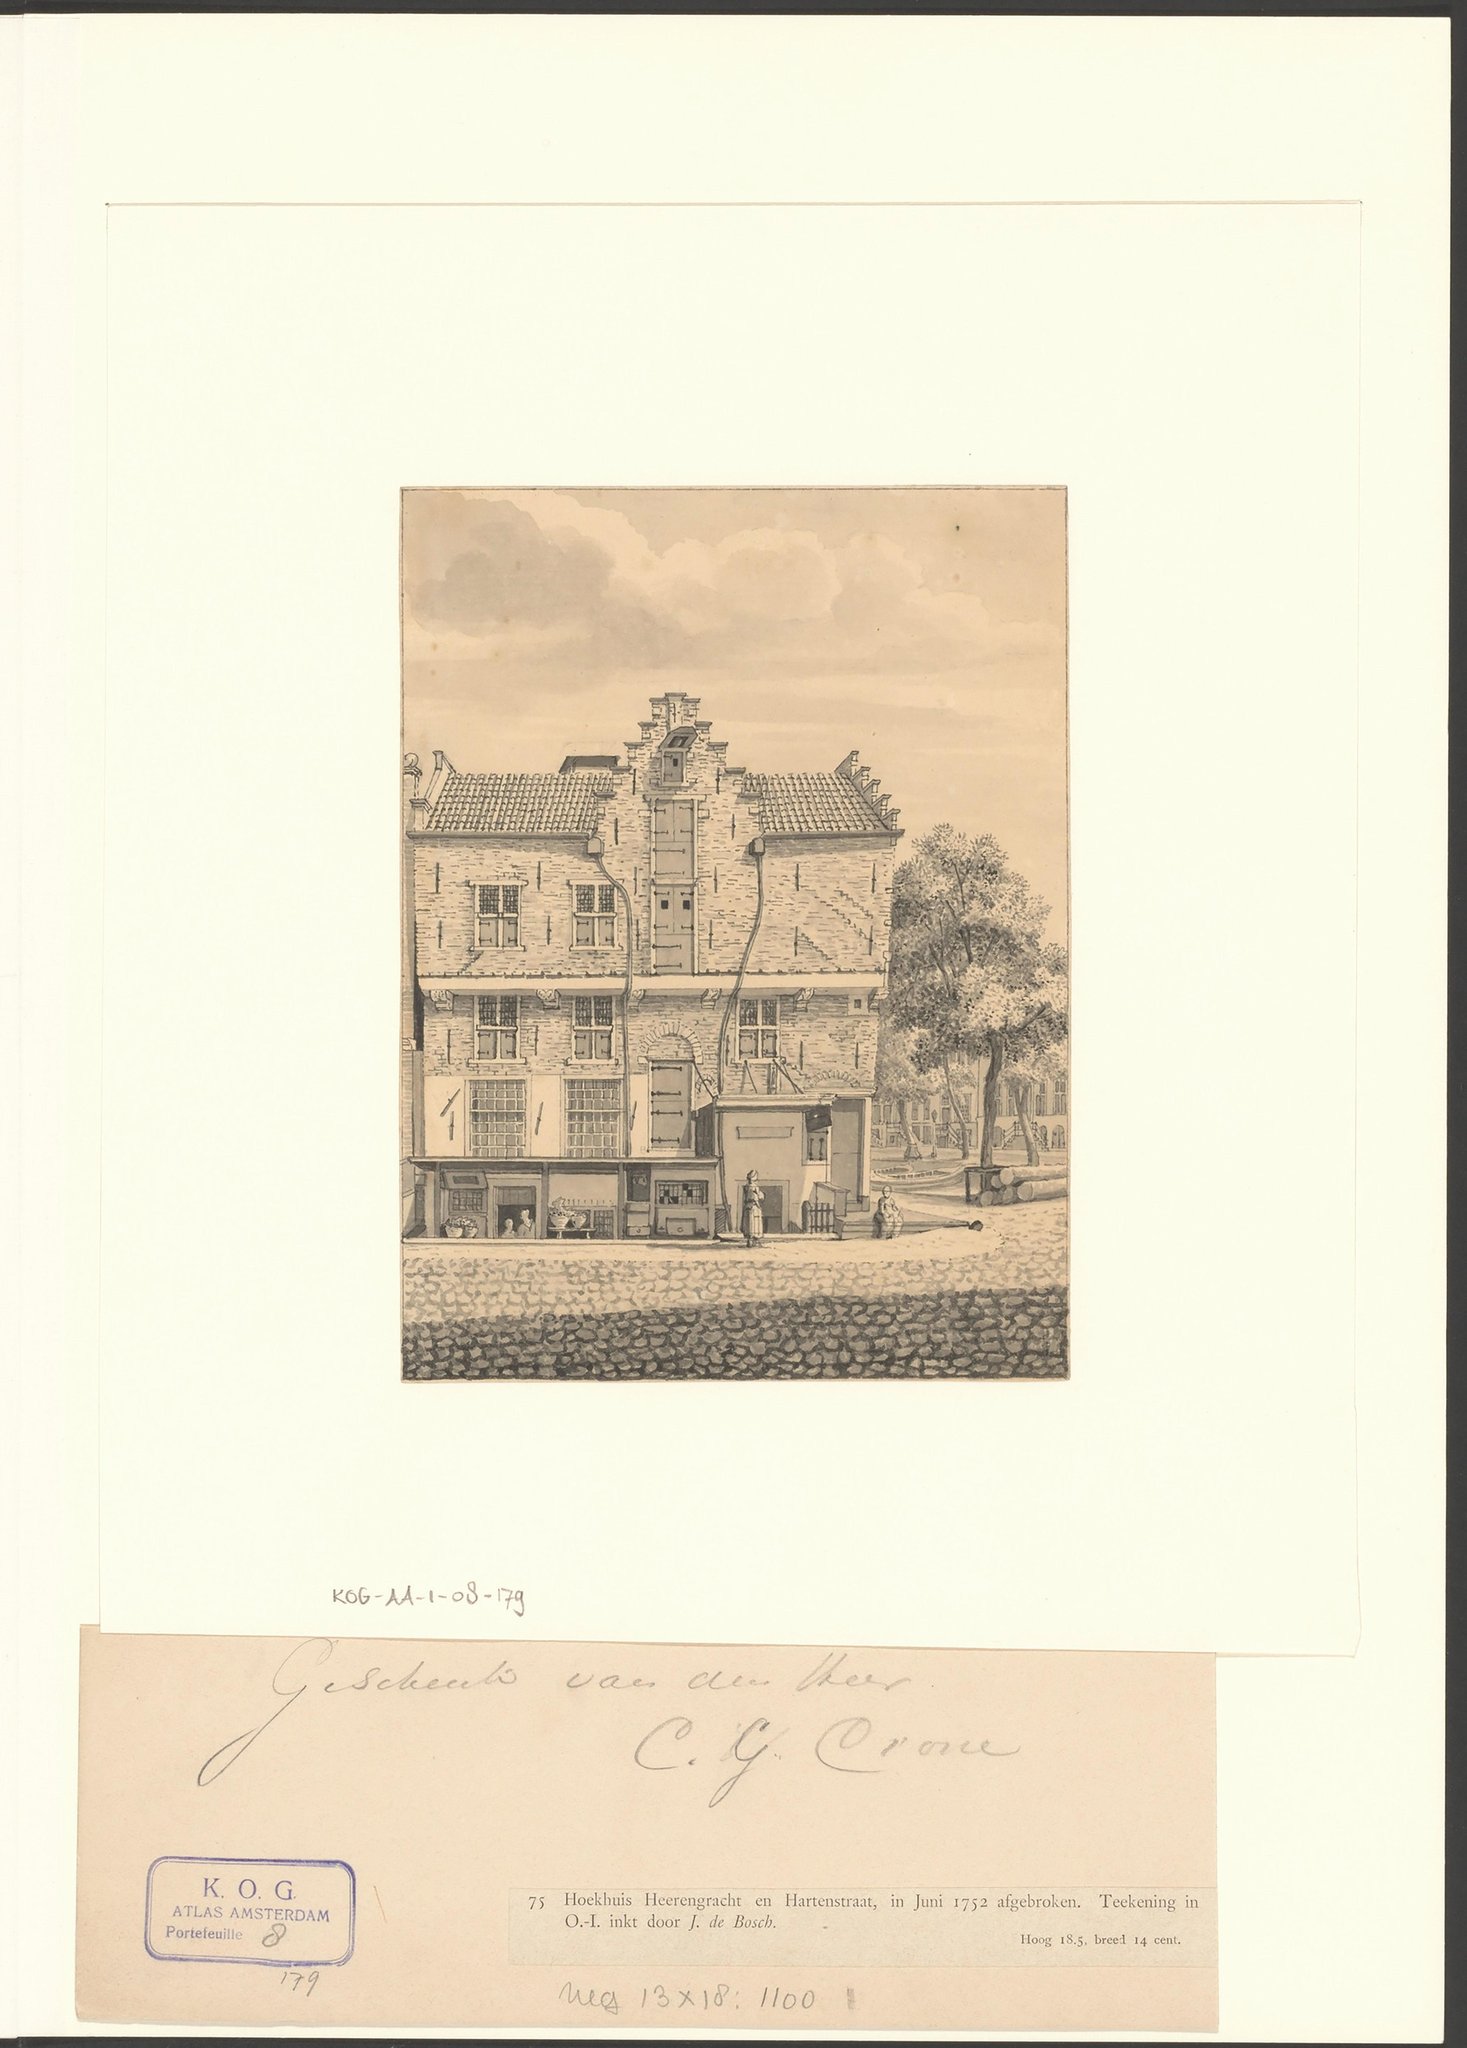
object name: drawing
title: Gezicht op een hoekhuis met trapgevels, hoek Herengracht en Hartenstraat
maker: johannes de bosch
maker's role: draughtsman, print maker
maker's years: 1713-1785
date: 1723-1752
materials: ink, paper, pencil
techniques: brush, pen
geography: amsterdam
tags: city-view in general; 'veduta', façade (of house or building), street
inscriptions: inscription: ‘Het hoekhuijs van de heeren gragt en harten straat. / afgebroken den 21ste Junij 1752.’, collector's mark: ‘8’ Lugt 1641b, signature: ‘Jan de Bosch.Fecit’, inscription: ‘Port. 8-179’, inscription: ‘Geschenk van den (...) 13 x 18: 1100’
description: Onderwerpsrubriek binnen de Atlas Amsterdam: Haarlemmerplein, Halvemaansteeg, Handboogstraat, Handelskade, Haringpakkerij, Hartenstraat, Hasseltsteeg (Dirk van), Heerengracht.